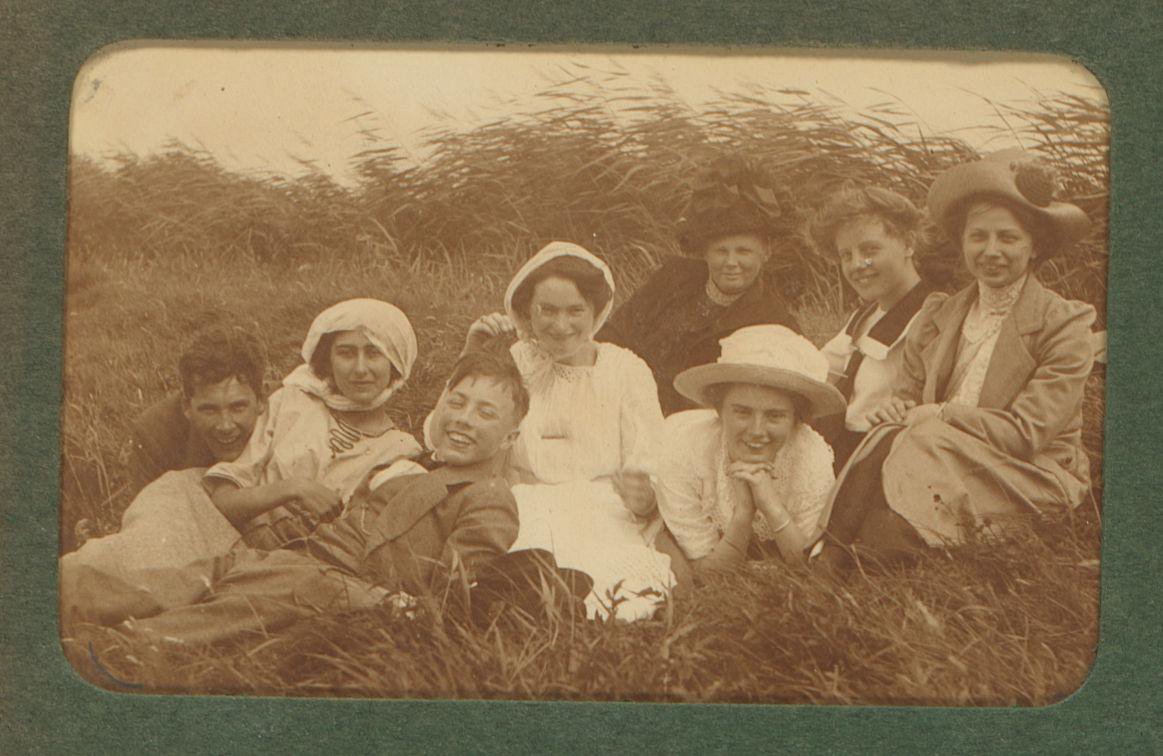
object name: album leaf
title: Groepsfoto in het gras, links Theo en Jenny Wichers naast Alexander Voormolen, daarnaast Wiesje en Anneke Merkus en drie onbekende personen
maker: Anonymous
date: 1910-1911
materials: paper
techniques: gelatin silver print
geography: gelderland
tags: rotterdam, the hague, artist, sculptor, jenny cornelia henriette wichers (jane), wiesje merkus, friends, gelderland